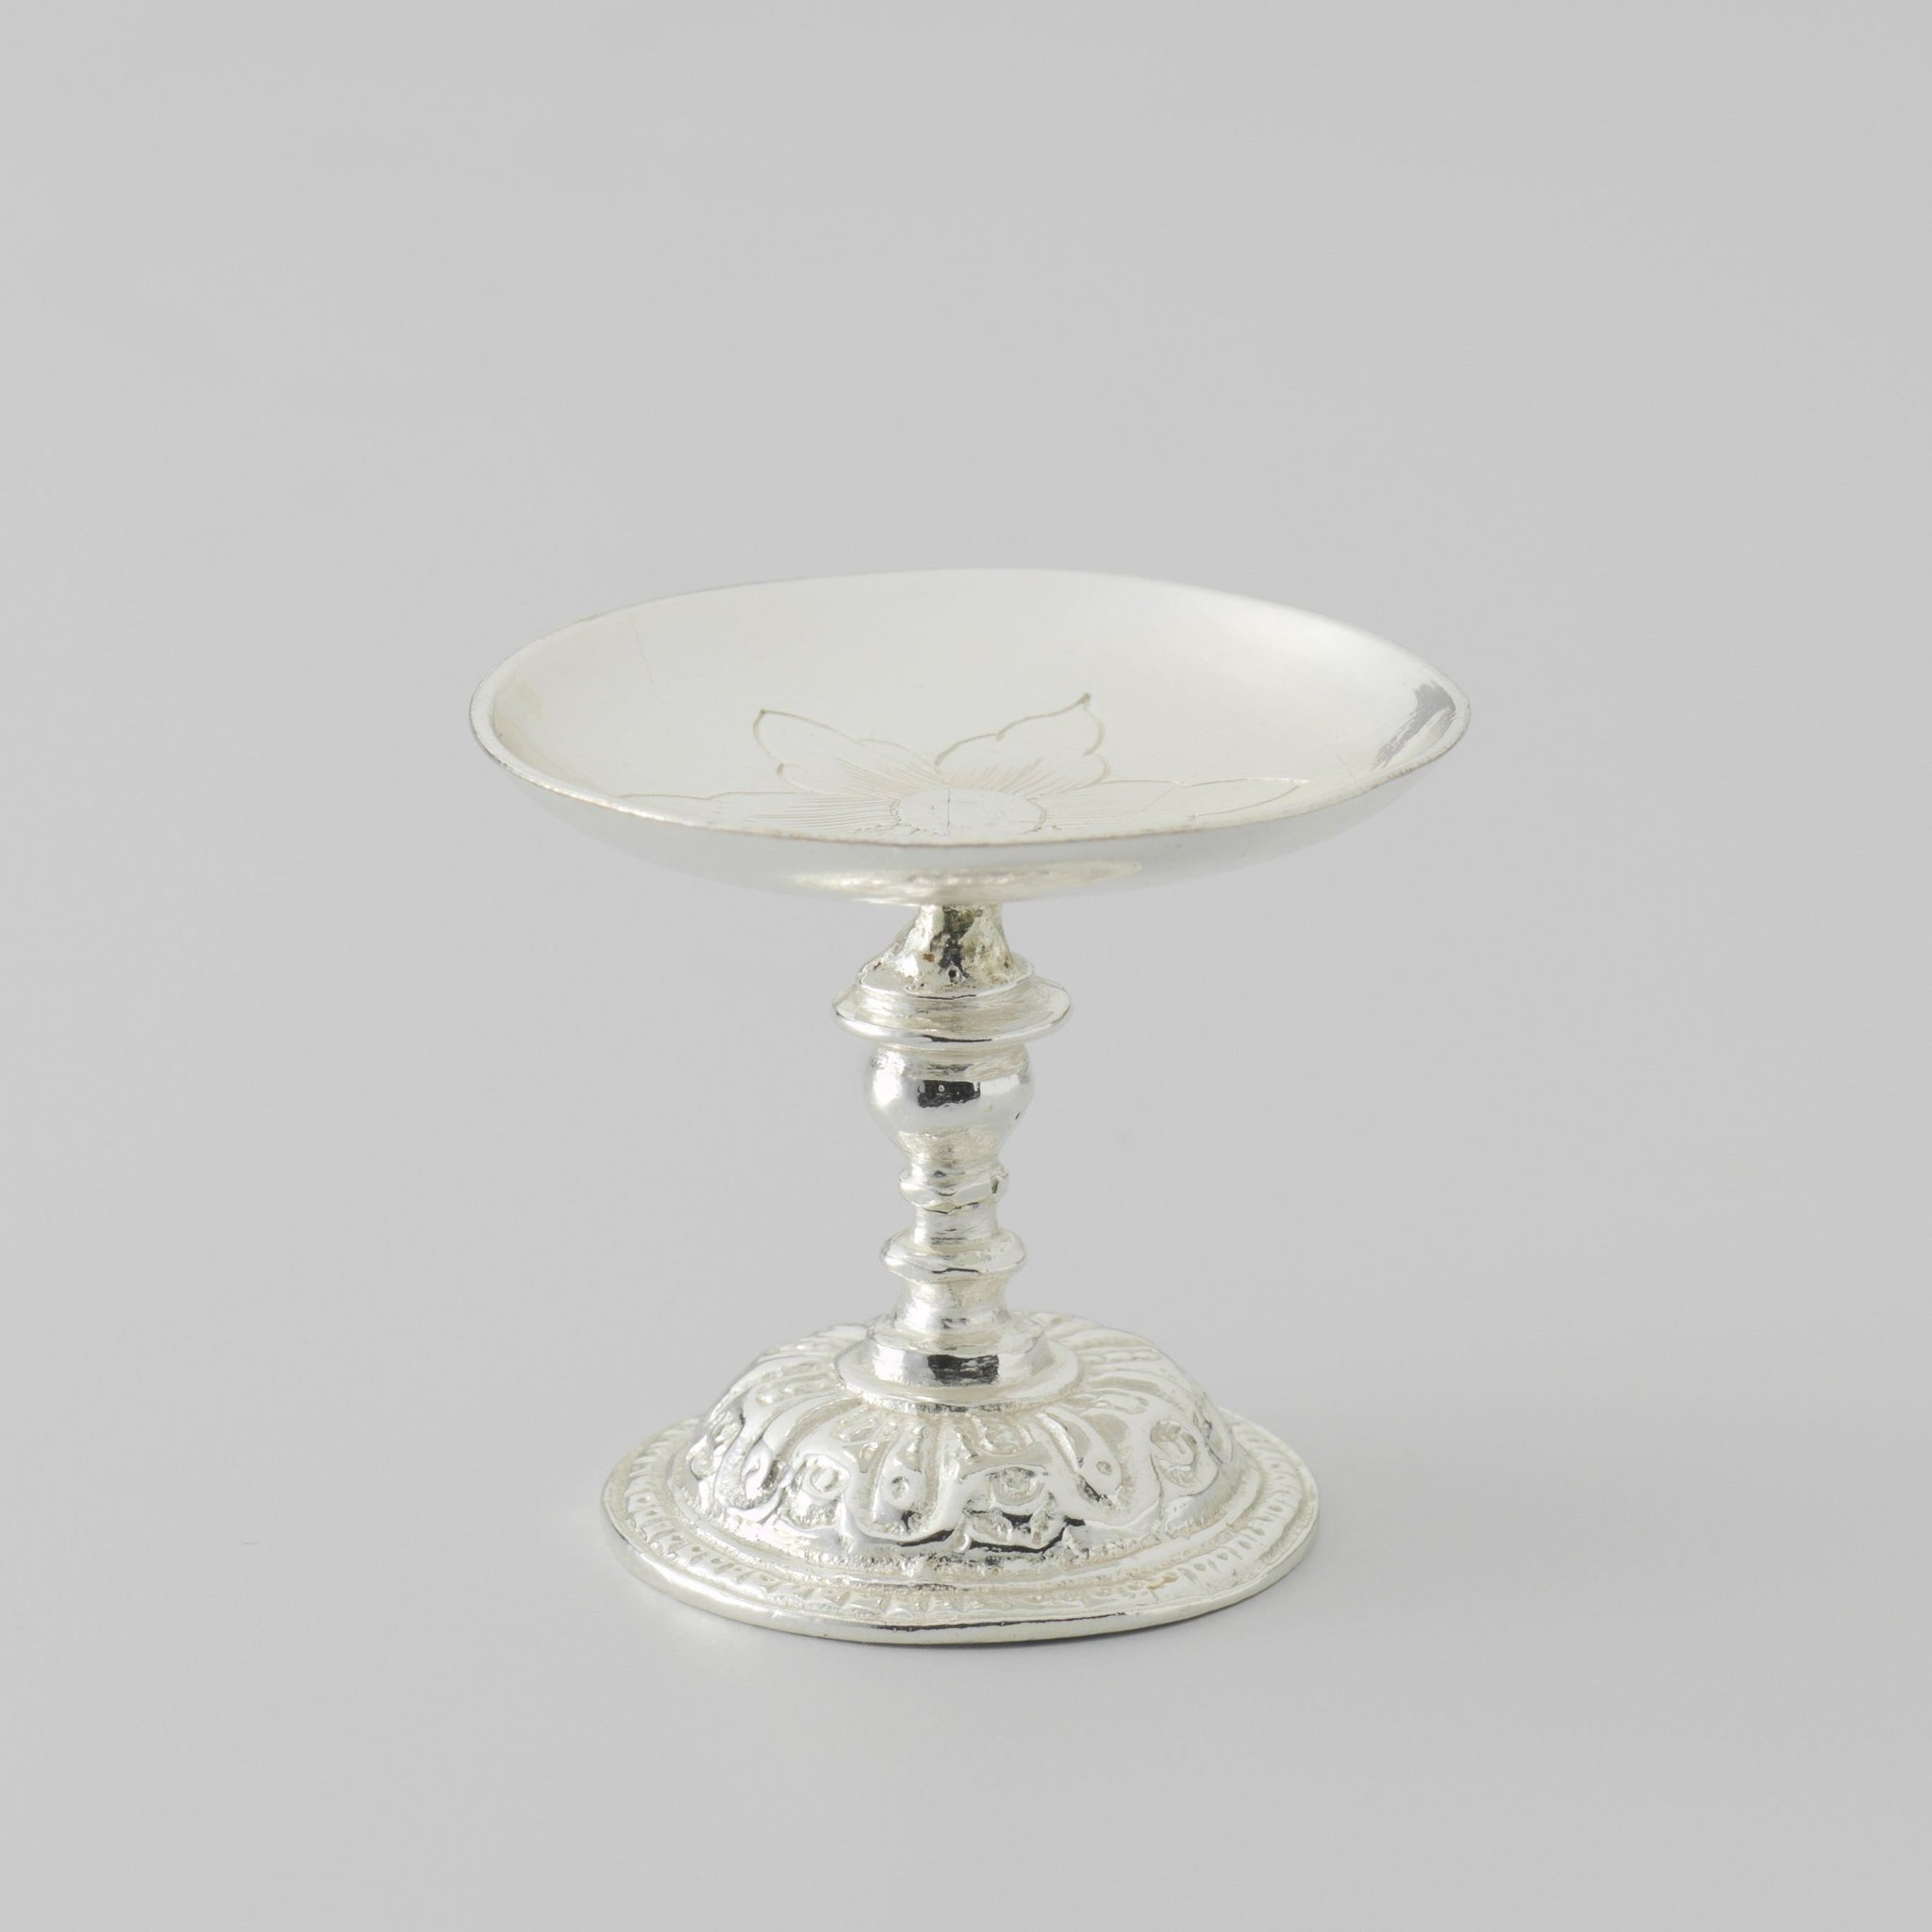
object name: miniature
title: Drinkschaal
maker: Anonymous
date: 1650-1700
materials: silver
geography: netherlands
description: Drinkschaal, rond, op balustervormige stam. De voet is gewelfd en gedecoreerd. In de schotel is een zesbladige bloem gegraveerd. De drinkschaal is niet gemerkt.